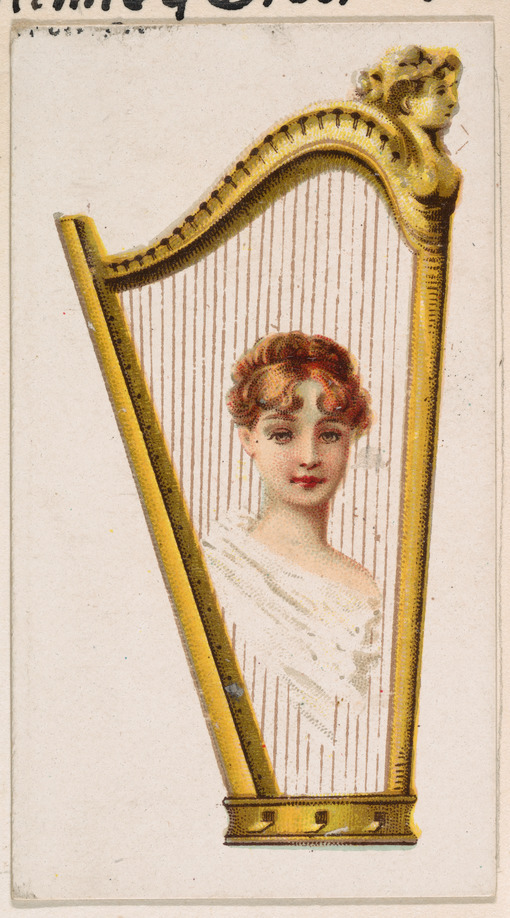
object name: print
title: Harp, from the Novelties series (N228, Type 5) issued by Kinney Bros.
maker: kinney brothers tobacco company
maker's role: publisher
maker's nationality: american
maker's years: 1869-2011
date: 1889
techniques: color lithograph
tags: women,harps